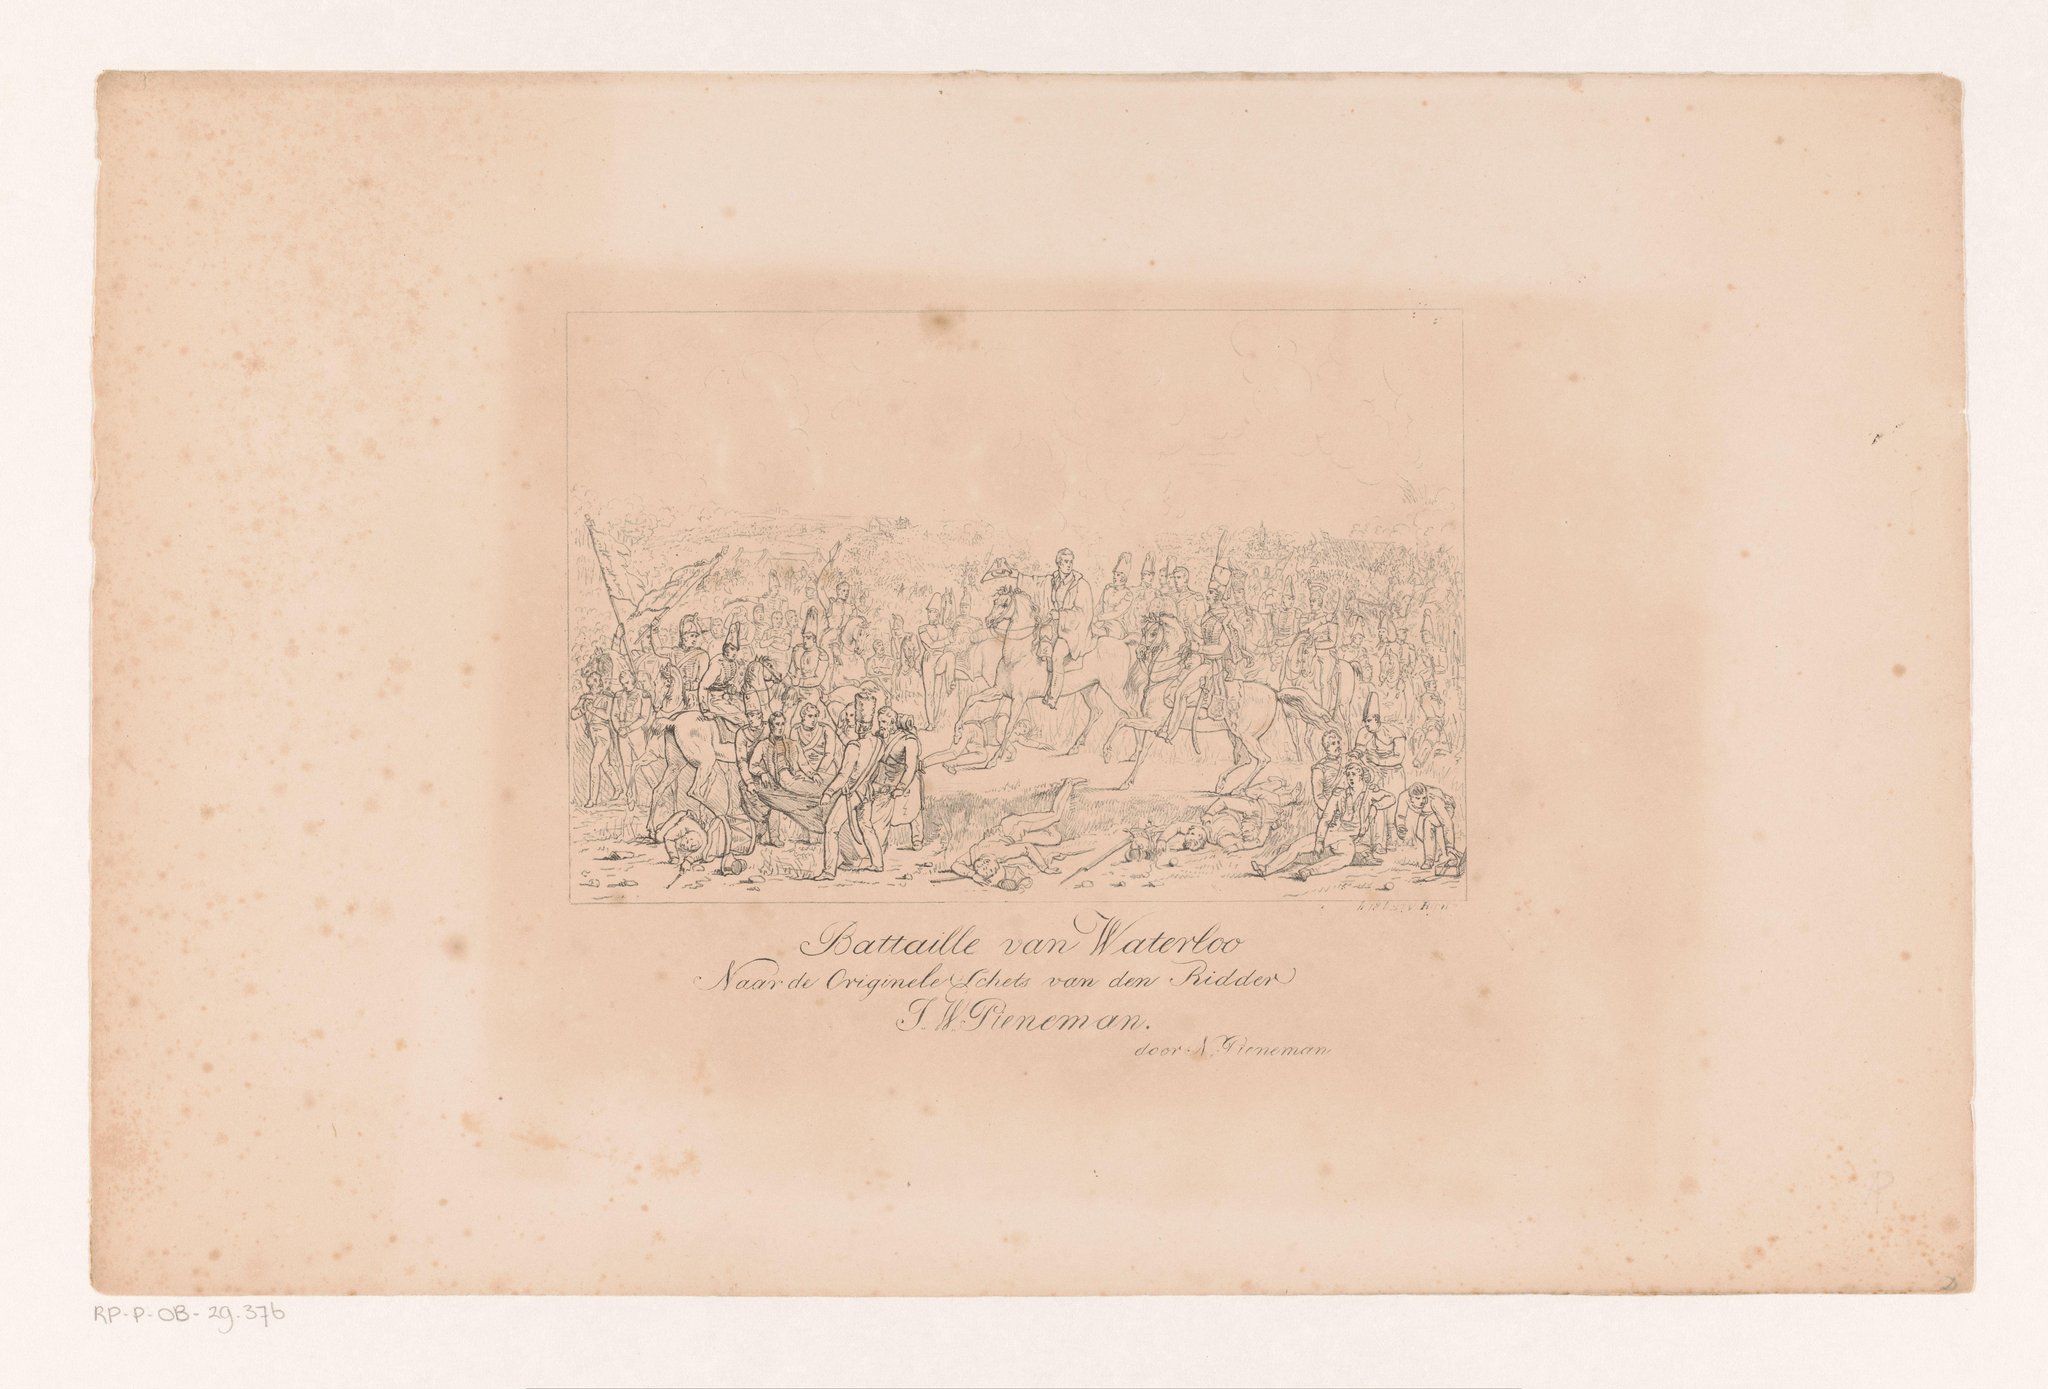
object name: print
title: Battaille van Waterloo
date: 1819-1860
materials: paper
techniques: lithograph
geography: netherlands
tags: the hague, william ii of the netherlands, walmer castle, arthur wellesley of wellington, putting out of action by wounding, charge ~ battle, waterloo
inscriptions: collector's mark: Lugt 2228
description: De slag bij Waterloo, 18 juni 1815. Gezicht op het slagveld op het moment dat de Engelse bevelhebber Wellington hoort dat Pruisische hulp onderweg is. De gewonde Willem, prins van Oranje, wordt links op de voorgrond weggevoerd. De bevelhebbers en andere officieren te paard staan in het midden, rechts op de voorgrond gewonde en dode soldaten. Op de achtergrond woeden de gevechten op het slagveld.